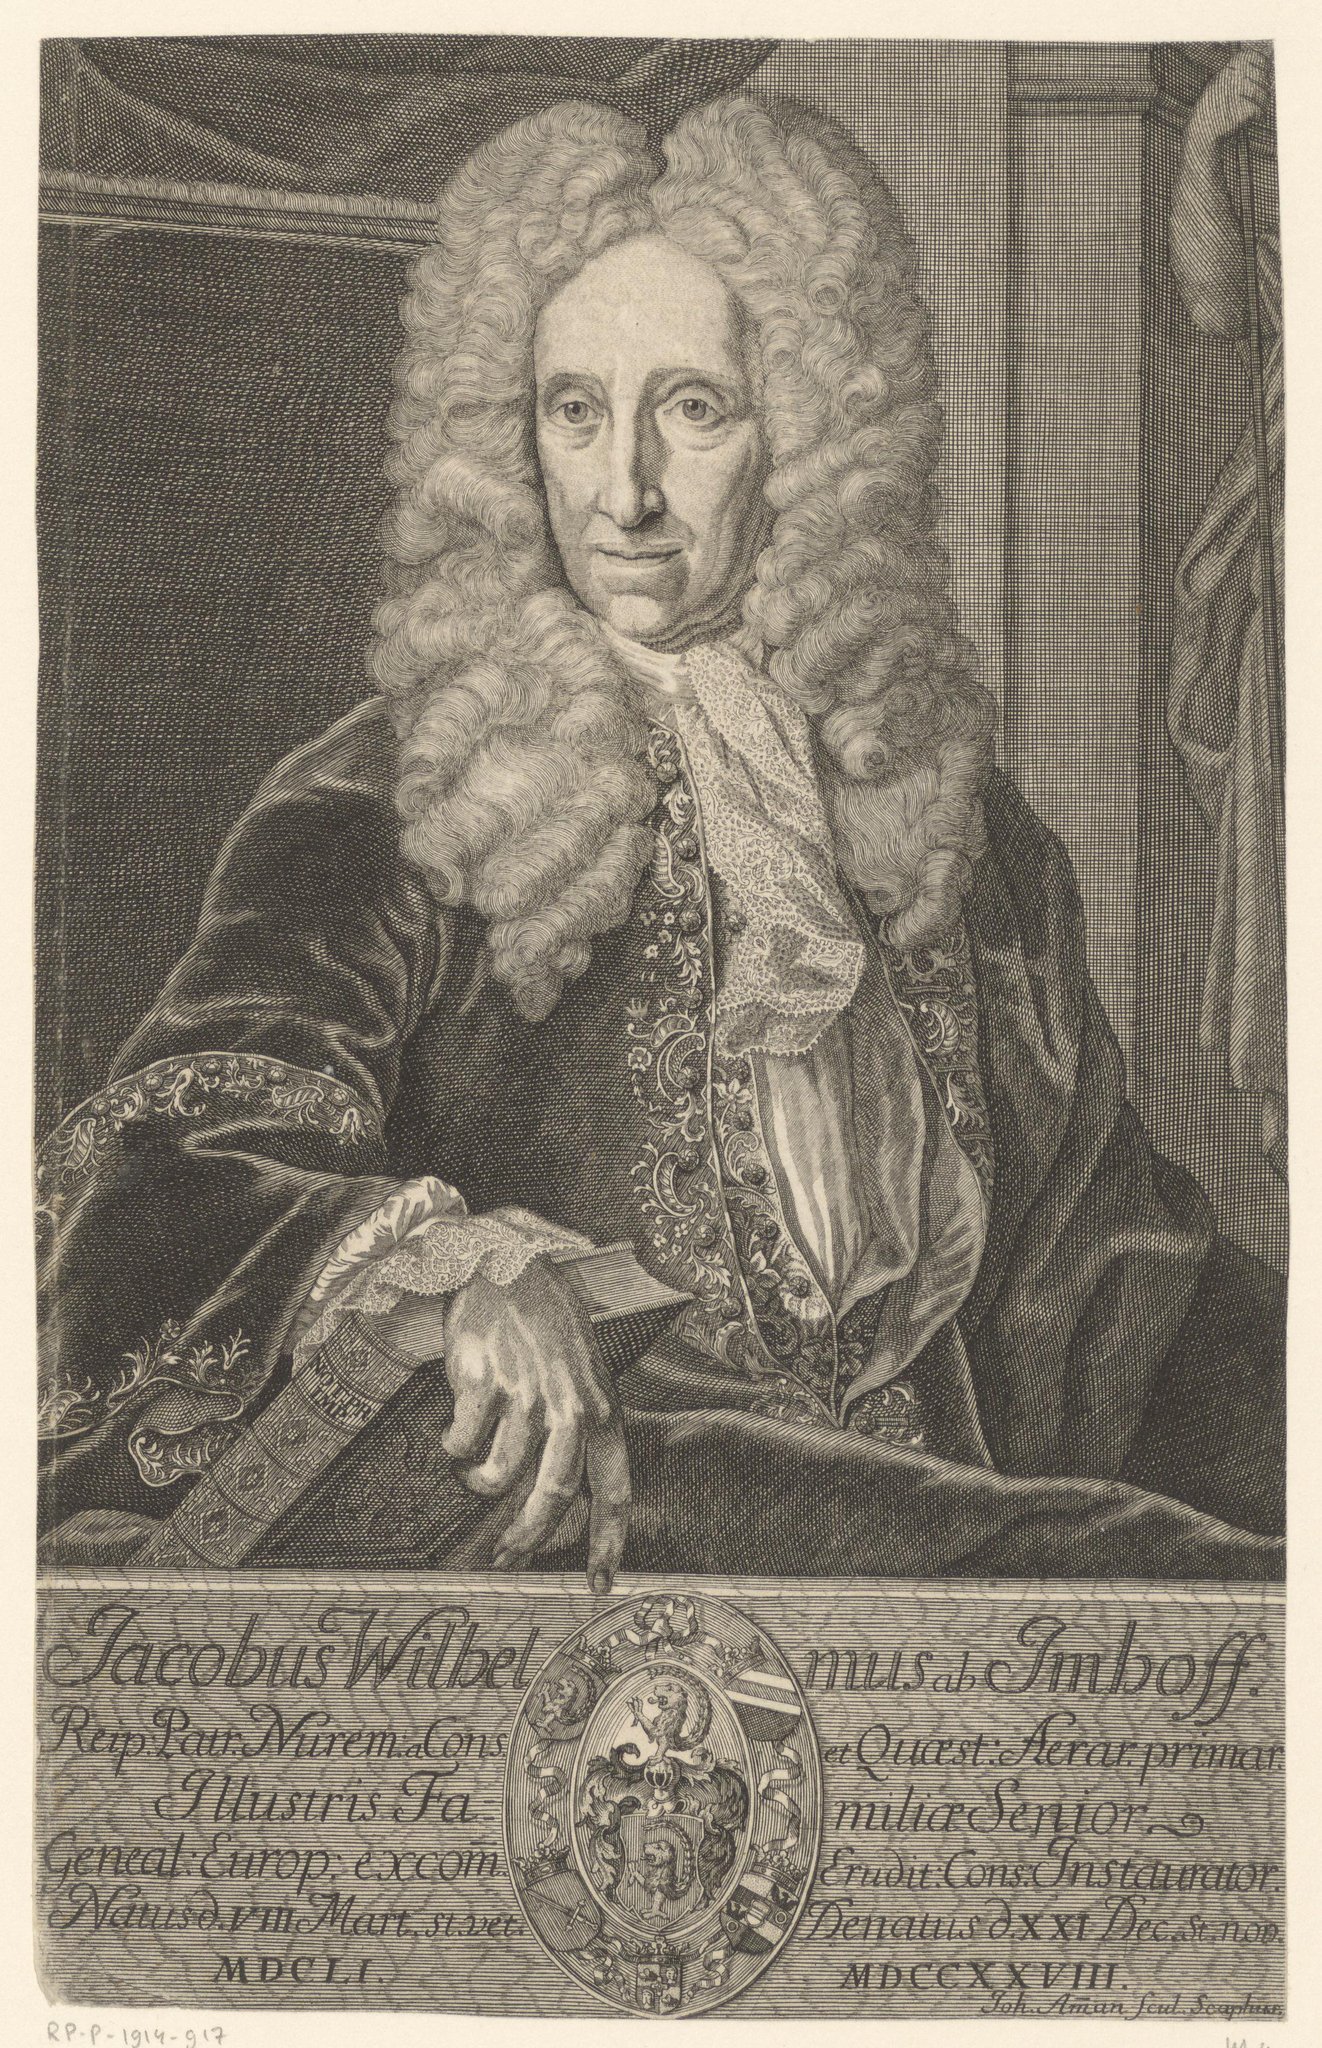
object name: print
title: Portret van Jakob Wilhelm Imhoff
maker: johannes ammann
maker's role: print maker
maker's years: 1695-1751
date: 1705-1751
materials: paper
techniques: engraving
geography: schaffhausen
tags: historical persons, book, armorial bearing, heraldry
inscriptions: collector's mark: Lugt 2228